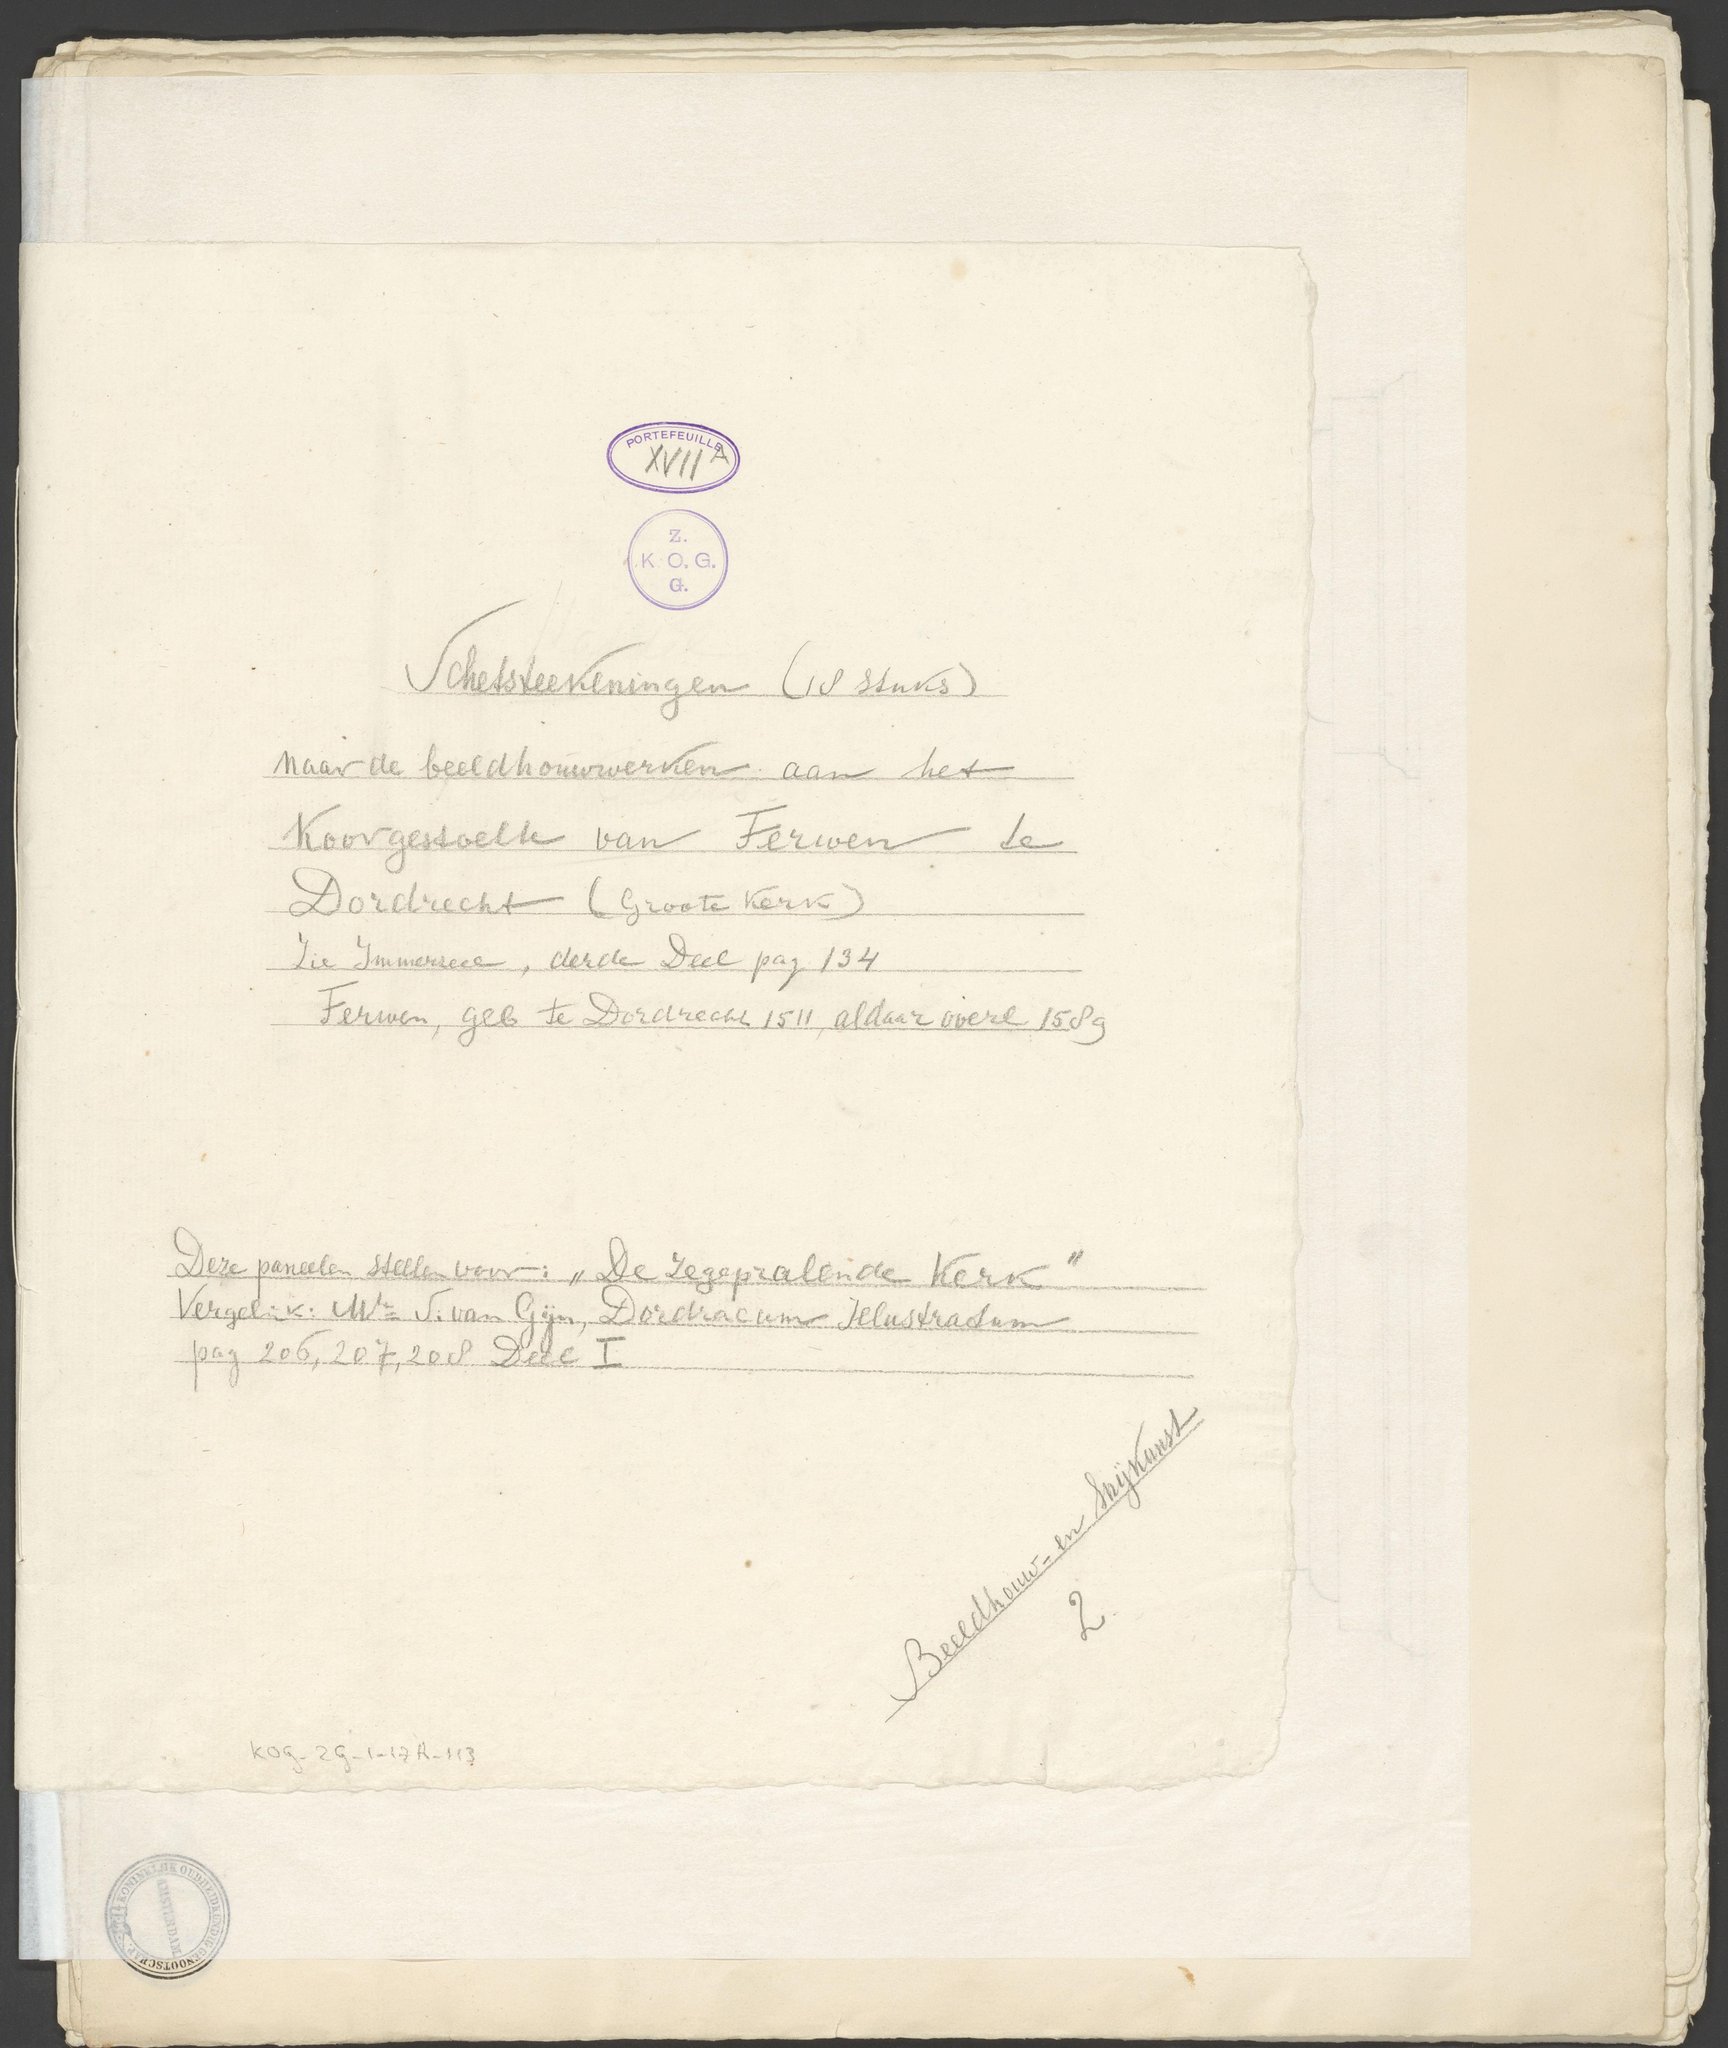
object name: wrapper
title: Omslag voor de serie tekeningen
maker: Anonymous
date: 1850-1940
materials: paper, pencil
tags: carving ~ applied arts, piece of sculpture, reproduction of a piece of sculpture, wood carver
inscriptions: collector's mark, collector's mark: Lugt 1641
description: Omslag voor de serie van 18 schetstekeningen naar het houtsnijwerk gemaakt door Jan Aertsz. Terwen in de jaren 1538-1542 voor de koorbanken in de Grote of Onze-Lieve-Vrouwekerk te Dordrecht. Met notities en literatuurverwijzingen. Onderwerpsrubrieken binnen de Atlas Zeden en Gewoonten: Beeldhouw- en snijkunst.